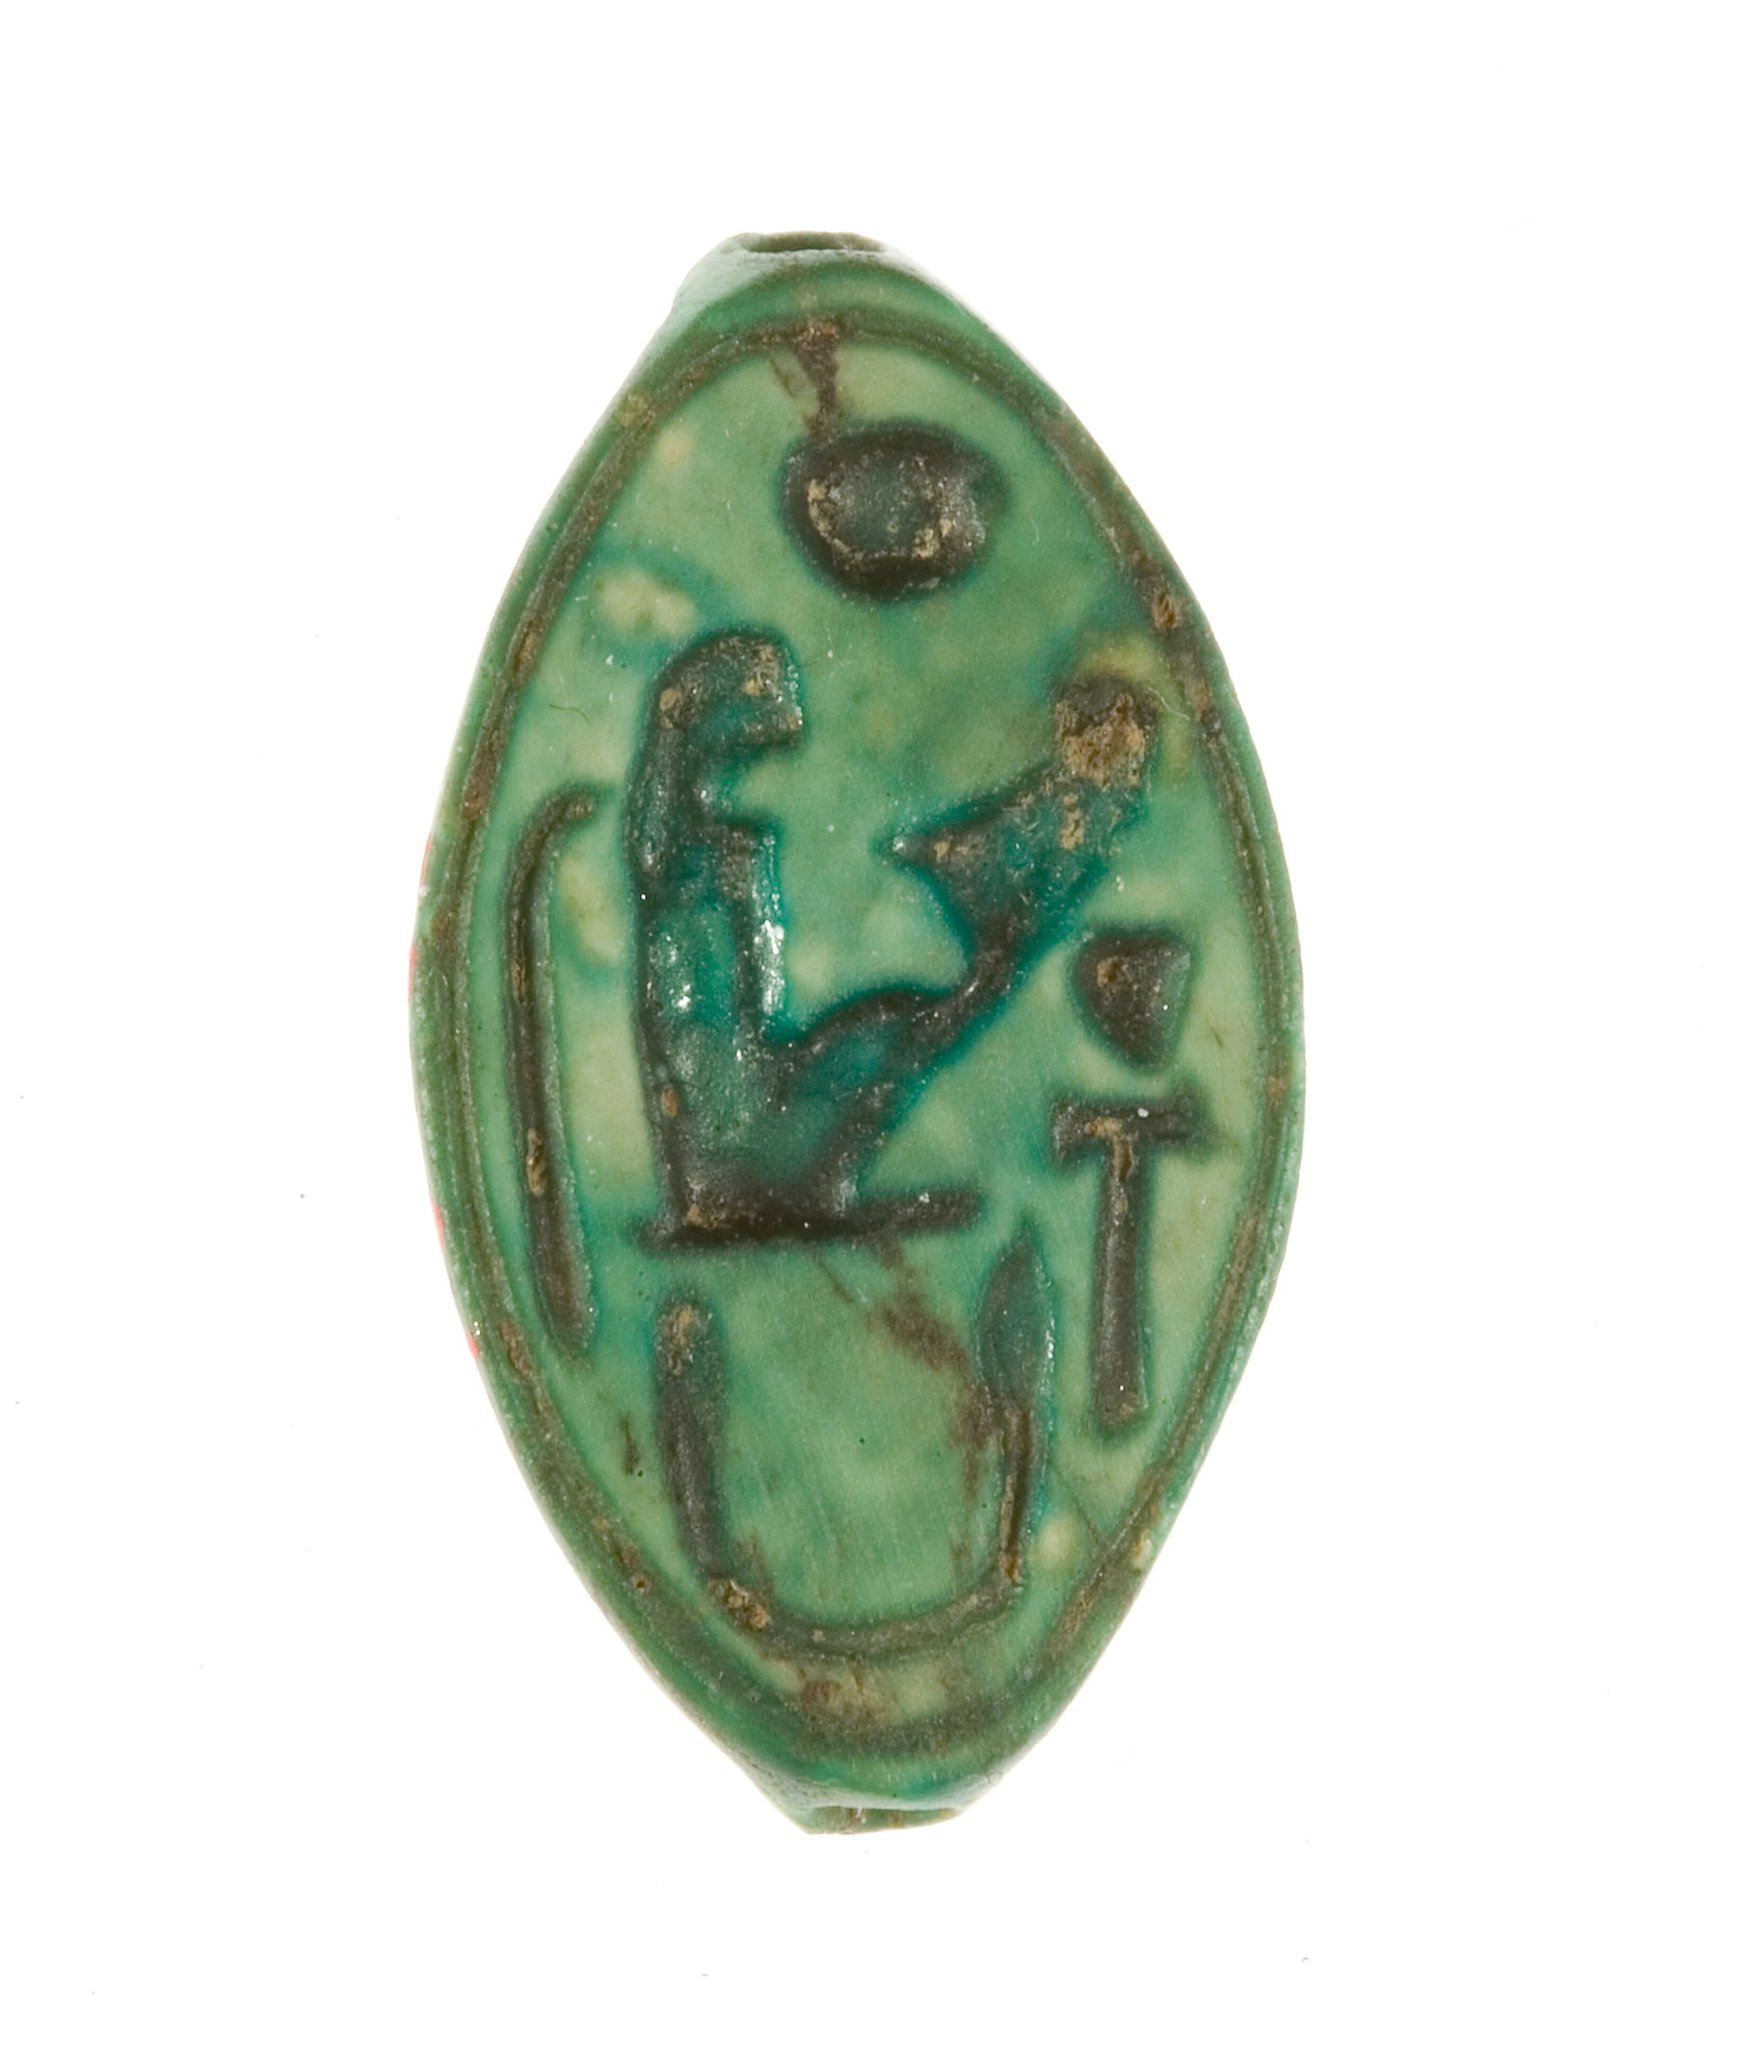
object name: cowroid, maatkare, ankhti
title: Cowroid Seal Inscirbed for Maatkare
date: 1479-1458 BCE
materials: stone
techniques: glazing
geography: egypt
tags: hieroglyphs